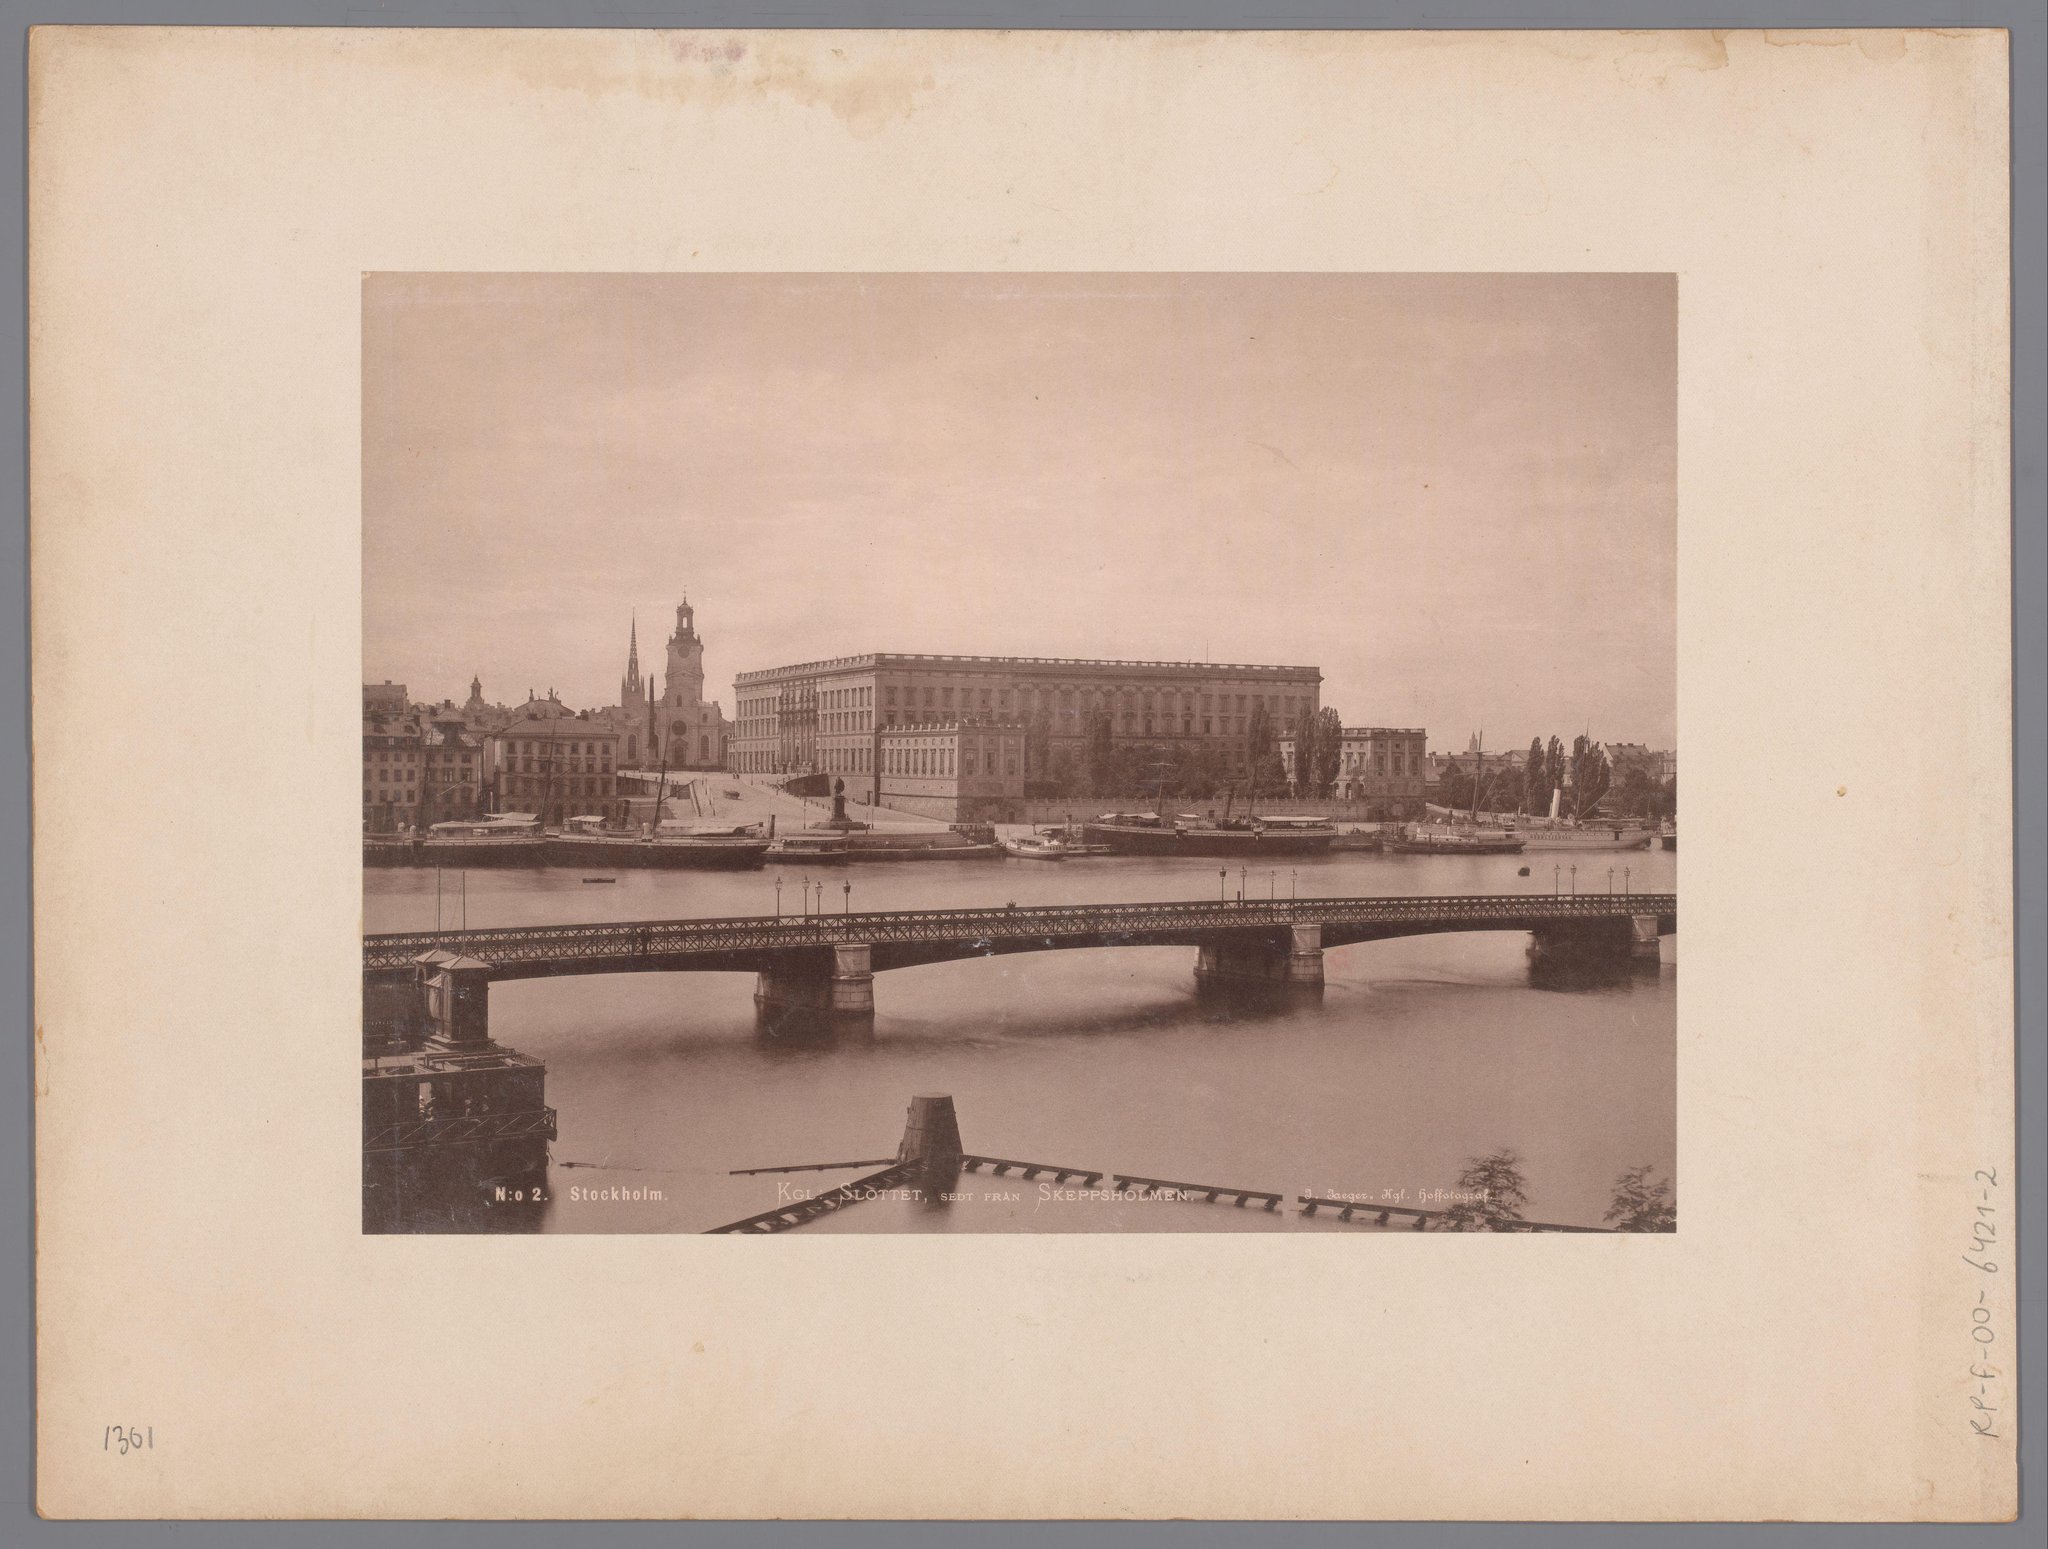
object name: photograph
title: Koninklijk paleis gezien van uit Skeppsholmen, Stockholm, Zweden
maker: johannes jaeger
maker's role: fotograaf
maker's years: 1832-1908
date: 1880-1900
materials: cardboard, paper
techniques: albumen print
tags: stockholm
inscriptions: number: ‘1361’, inscription: ‘N;o 2. Stockholm. KGL: SLOTTET, SEDT FRAN SKEPPSHOLMEN.’